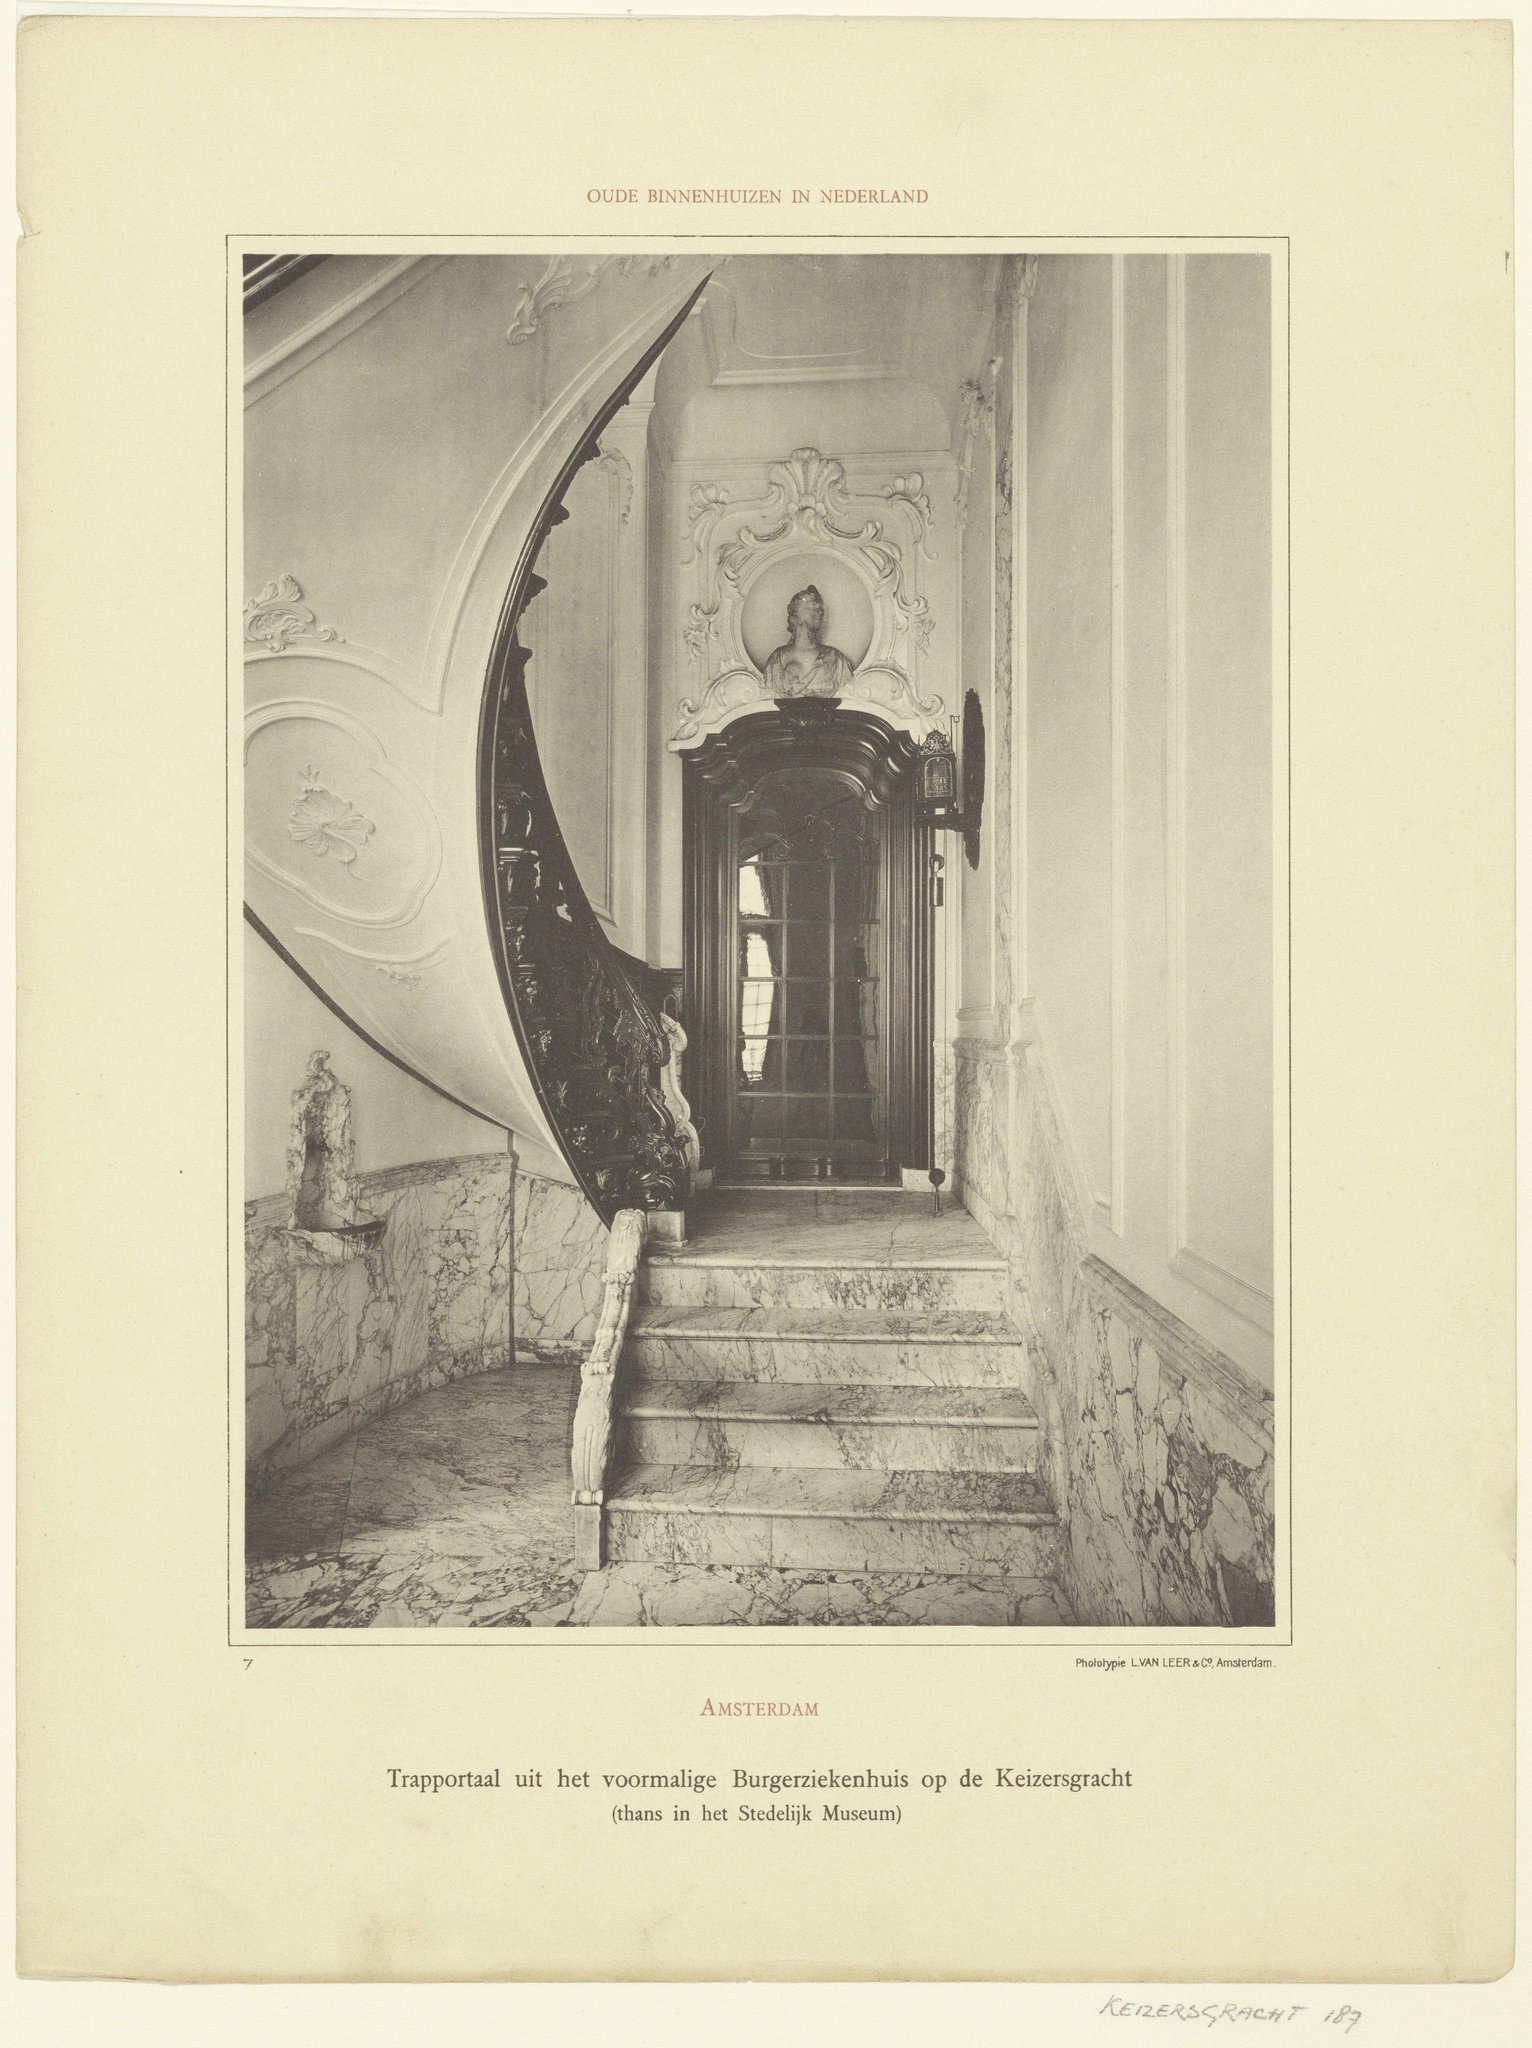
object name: architectural element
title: Onderdelen van het trapportaal uit het pand aan de Keizersgracht 187 te Amsterdam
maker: Anonymous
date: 1740-1760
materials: wood, marble